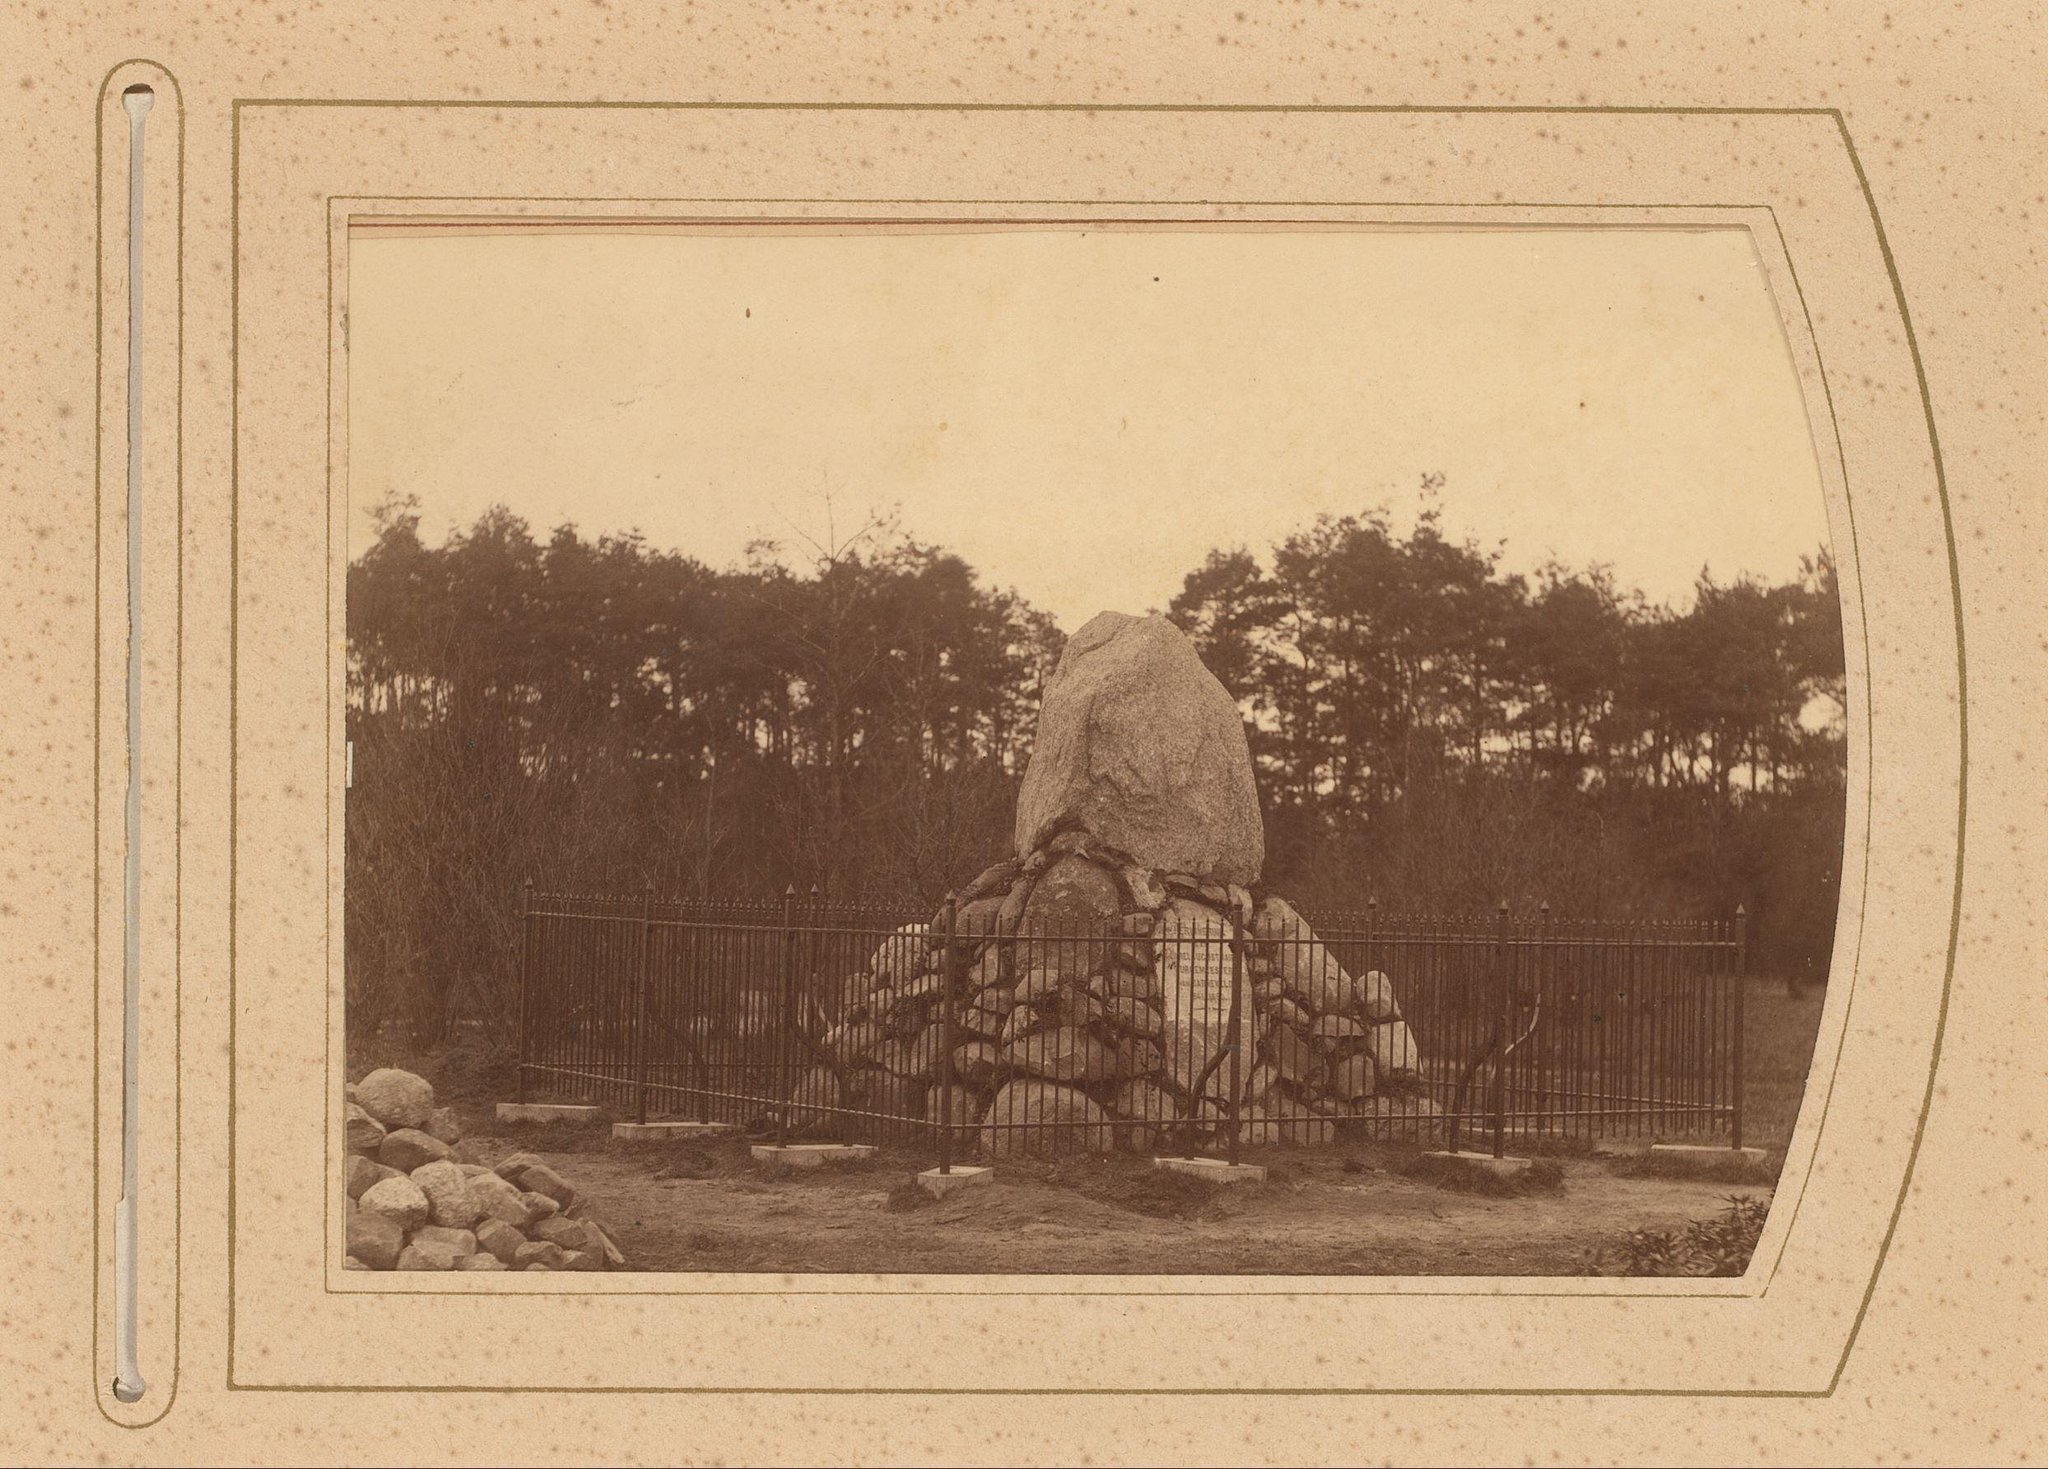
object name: photograph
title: Gezicht op een monument, opgericht ter herinnering aan een burgemeester van Barneveld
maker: Anonymous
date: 1880-1900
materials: cardboard, photographic support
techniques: albumen print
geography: barneveld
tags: monument, statue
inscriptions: collector's mark: ‘Algemeene Boekhandel/ Kantoorhandel en Leesbibliotheek/ Wde. P. Andreae Menger/ Barneveld’, number: ‘7,-’